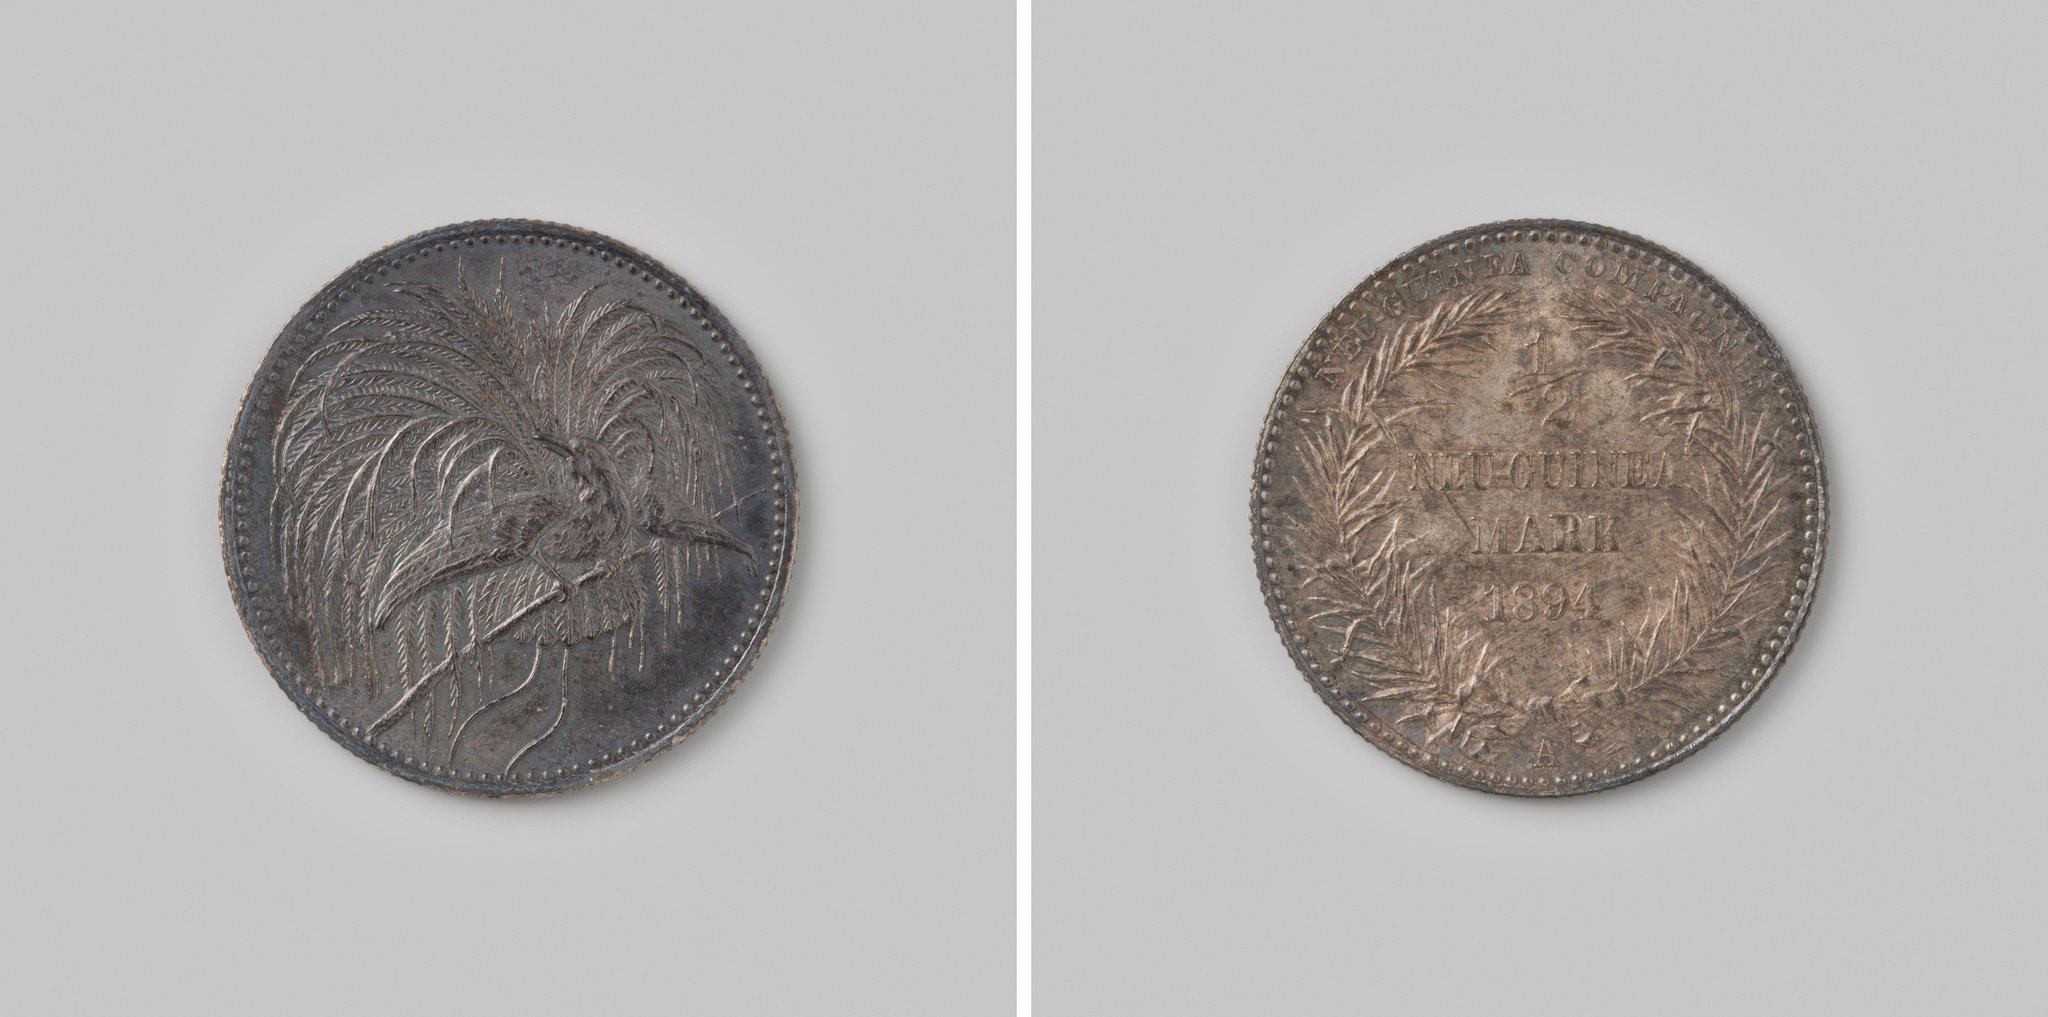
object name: coin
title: Neuguinea ½ Mark uit Duits Nieuw Guinea, 1894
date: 1894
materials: silver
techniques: striking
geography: berlin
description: Zilveren munt. Voorzijde: paradijsvogel met gespreide vleugels op tak. Jaartal onderaan. Keerzijde: tussen twee samengebonden takken waarde-aanduiding in drie regels, waaronder jaartal. Onderaan letter A [=Berlijn]. Kartelrand.